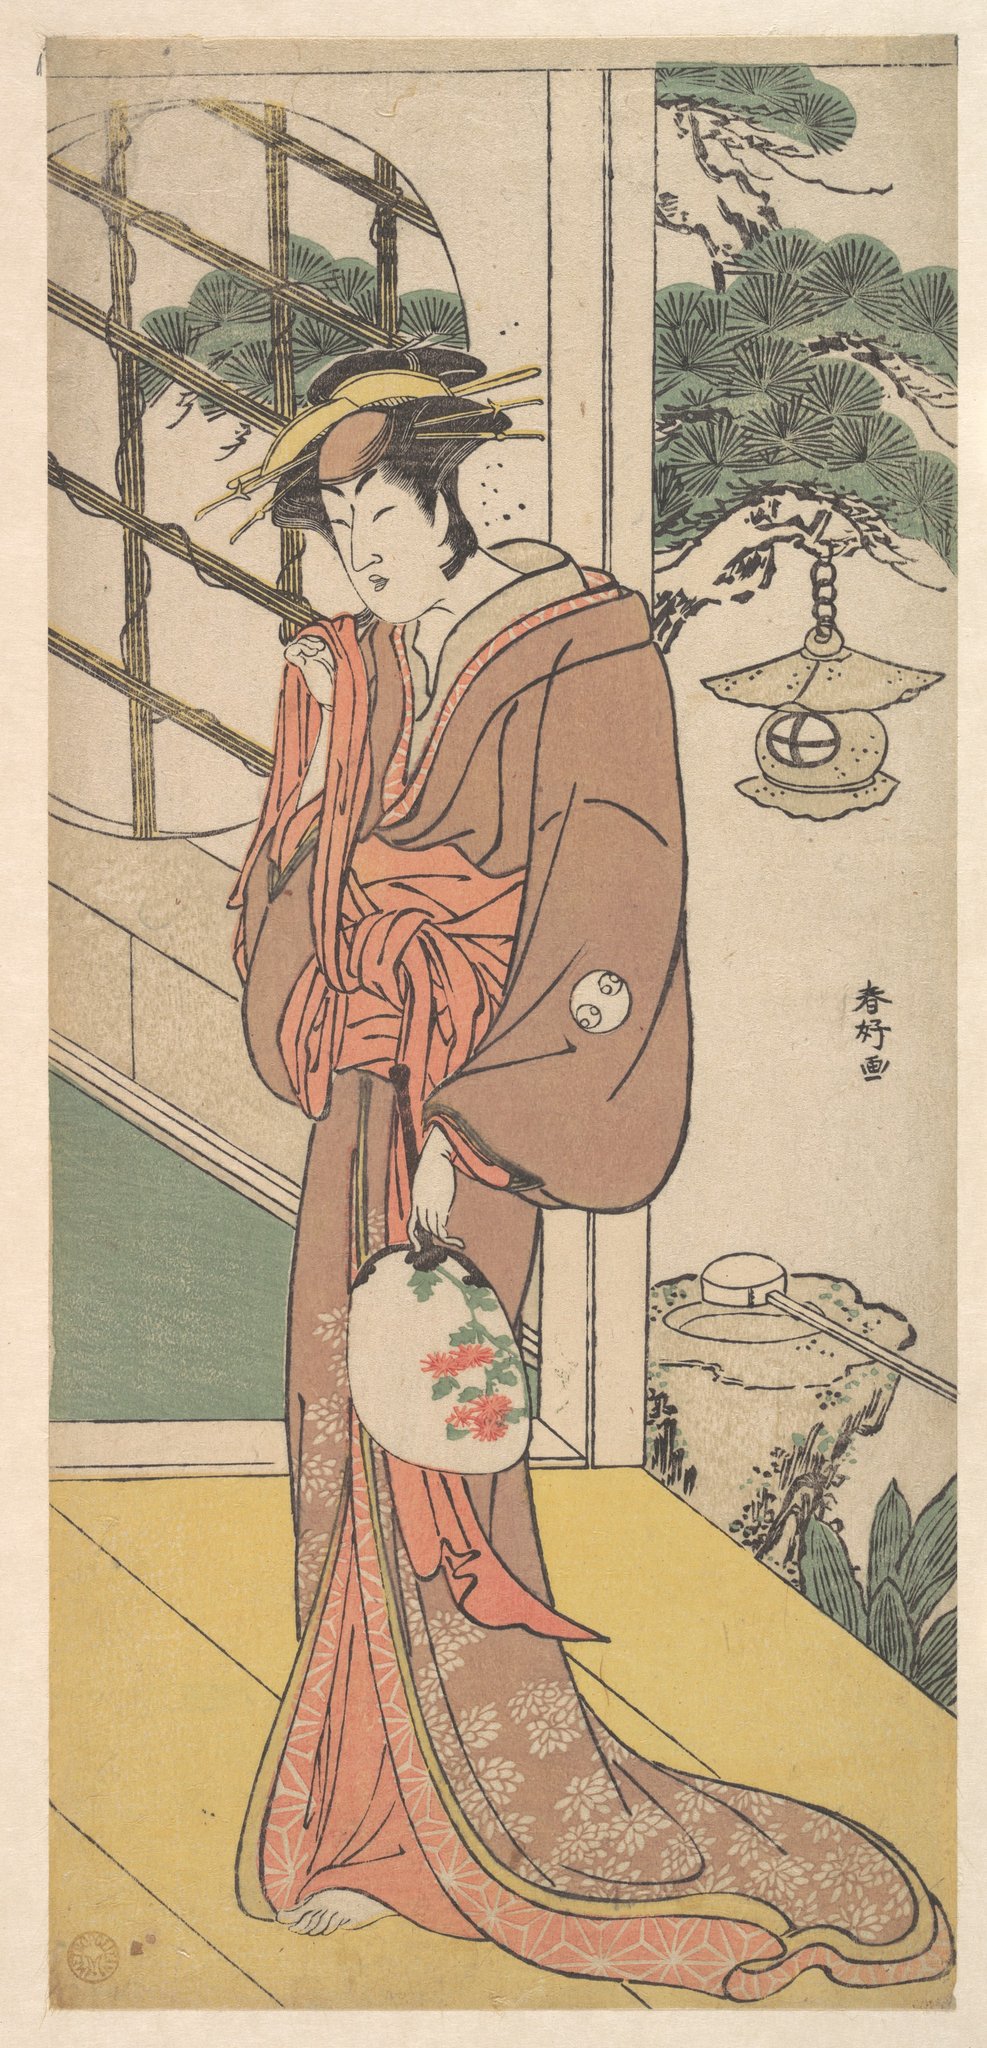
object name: print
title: Arashi Ryuzo as a Tall Woman Standing on the Engawa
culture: japanese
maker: katsukawa shunkō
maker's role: artist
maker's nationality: japanese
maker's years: 1743-1812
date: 1789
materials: ink, paper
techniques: woodblock print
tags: women,trees,actors